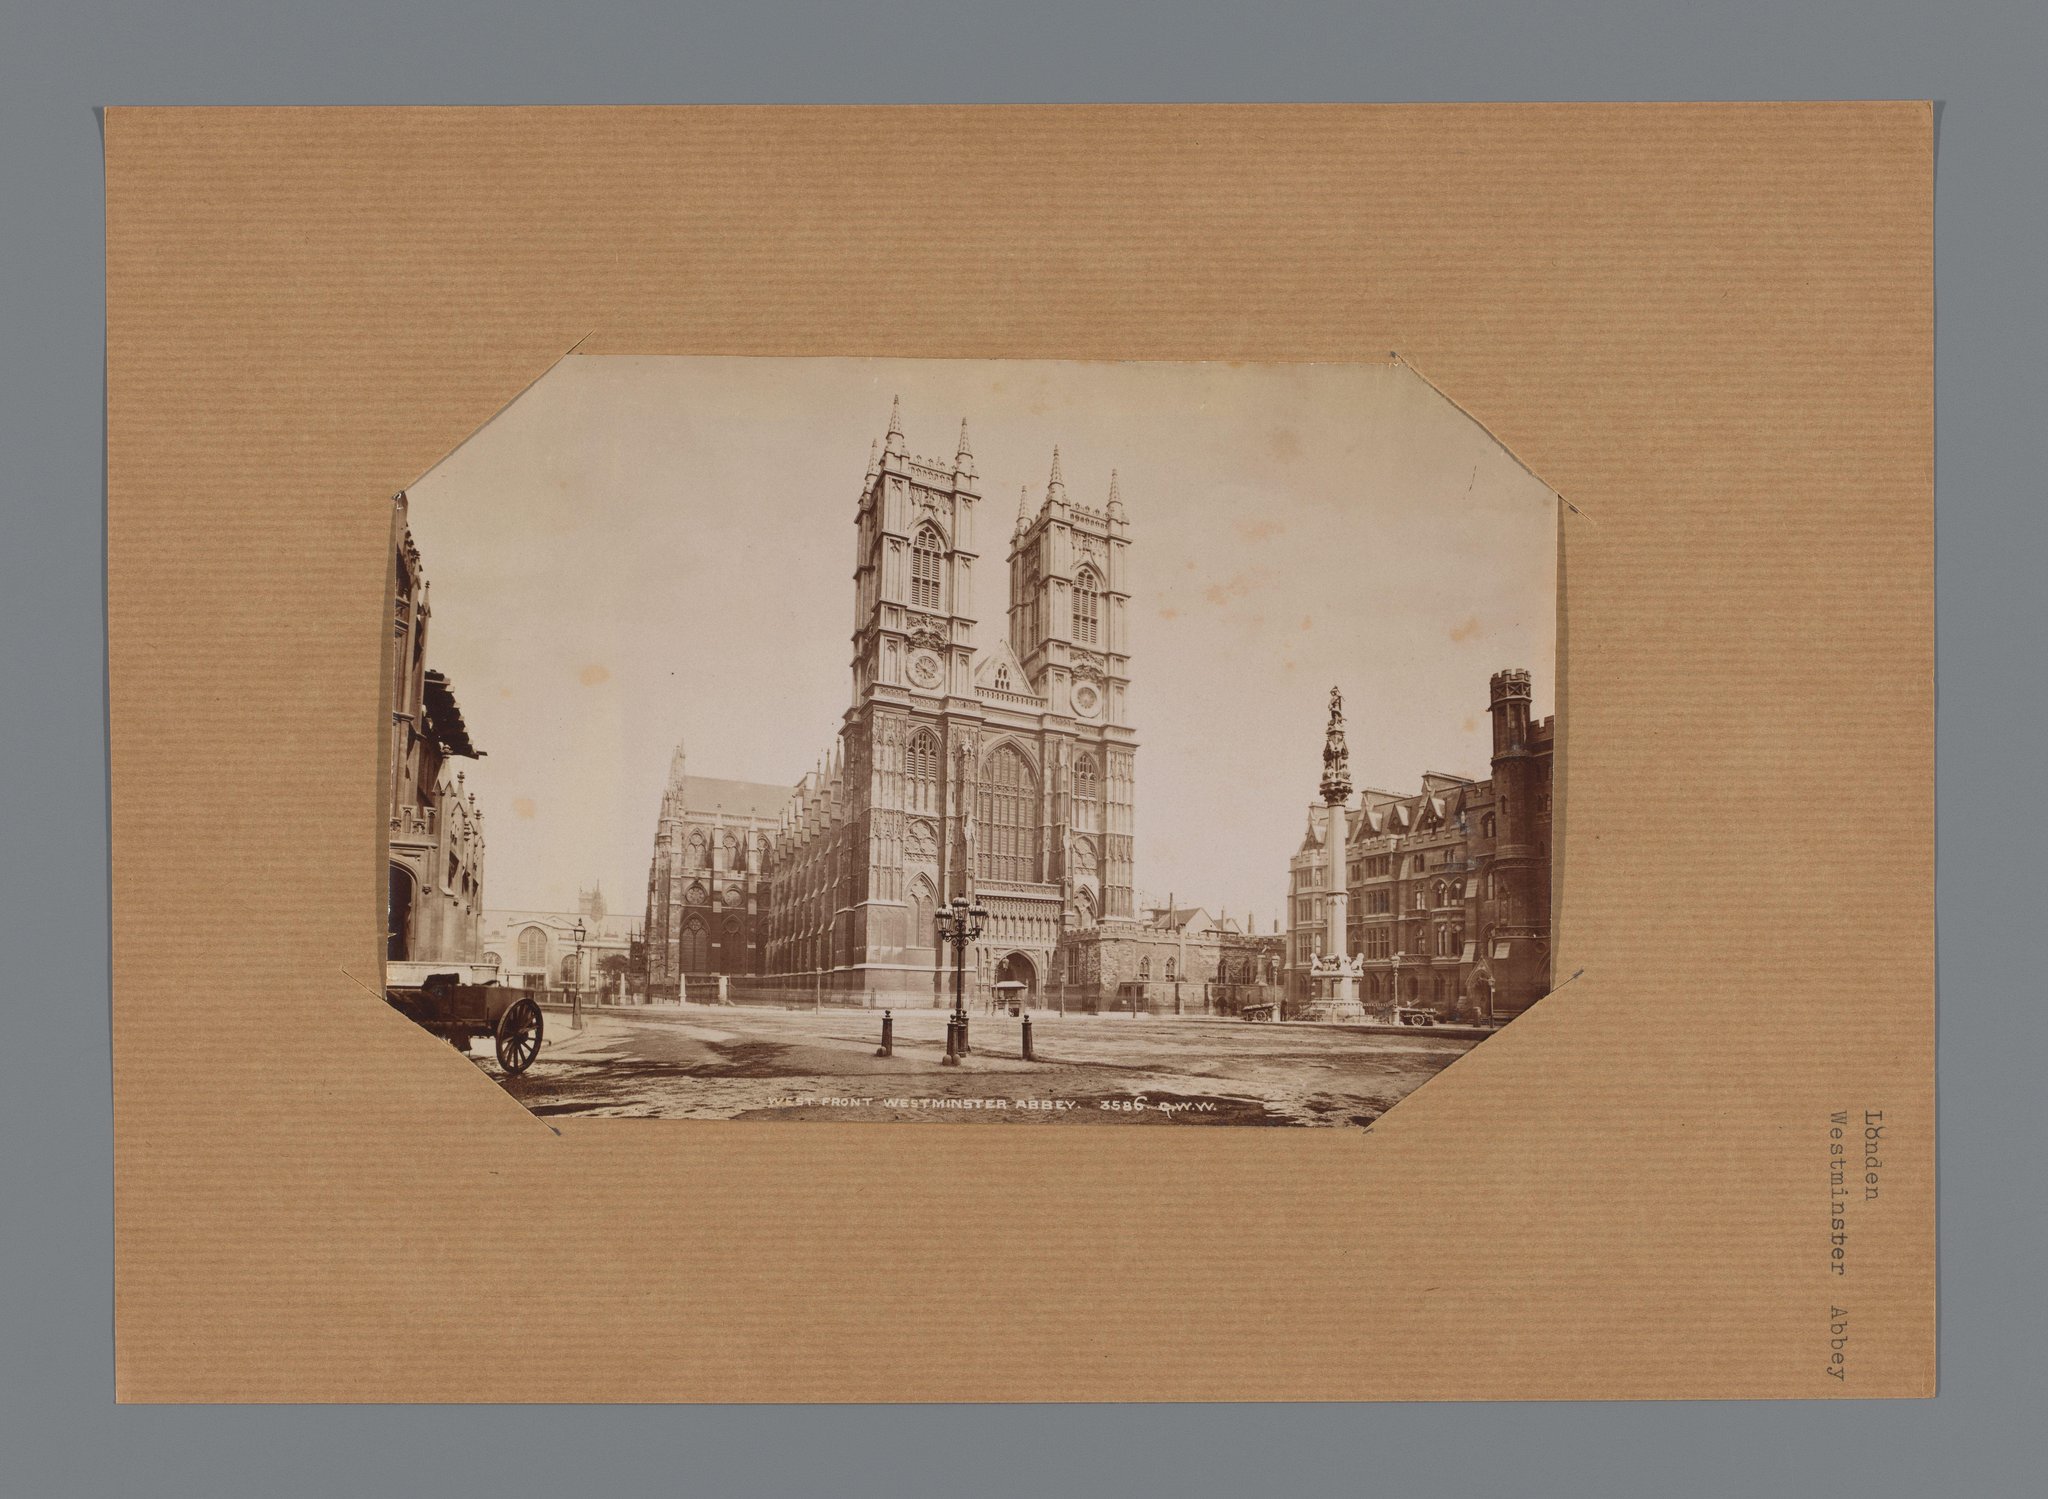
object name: photograph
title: Londen. Westminster Abbey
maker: Anonymous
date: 1850-1900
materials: photographic support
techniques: albumen print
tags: westminster abbey